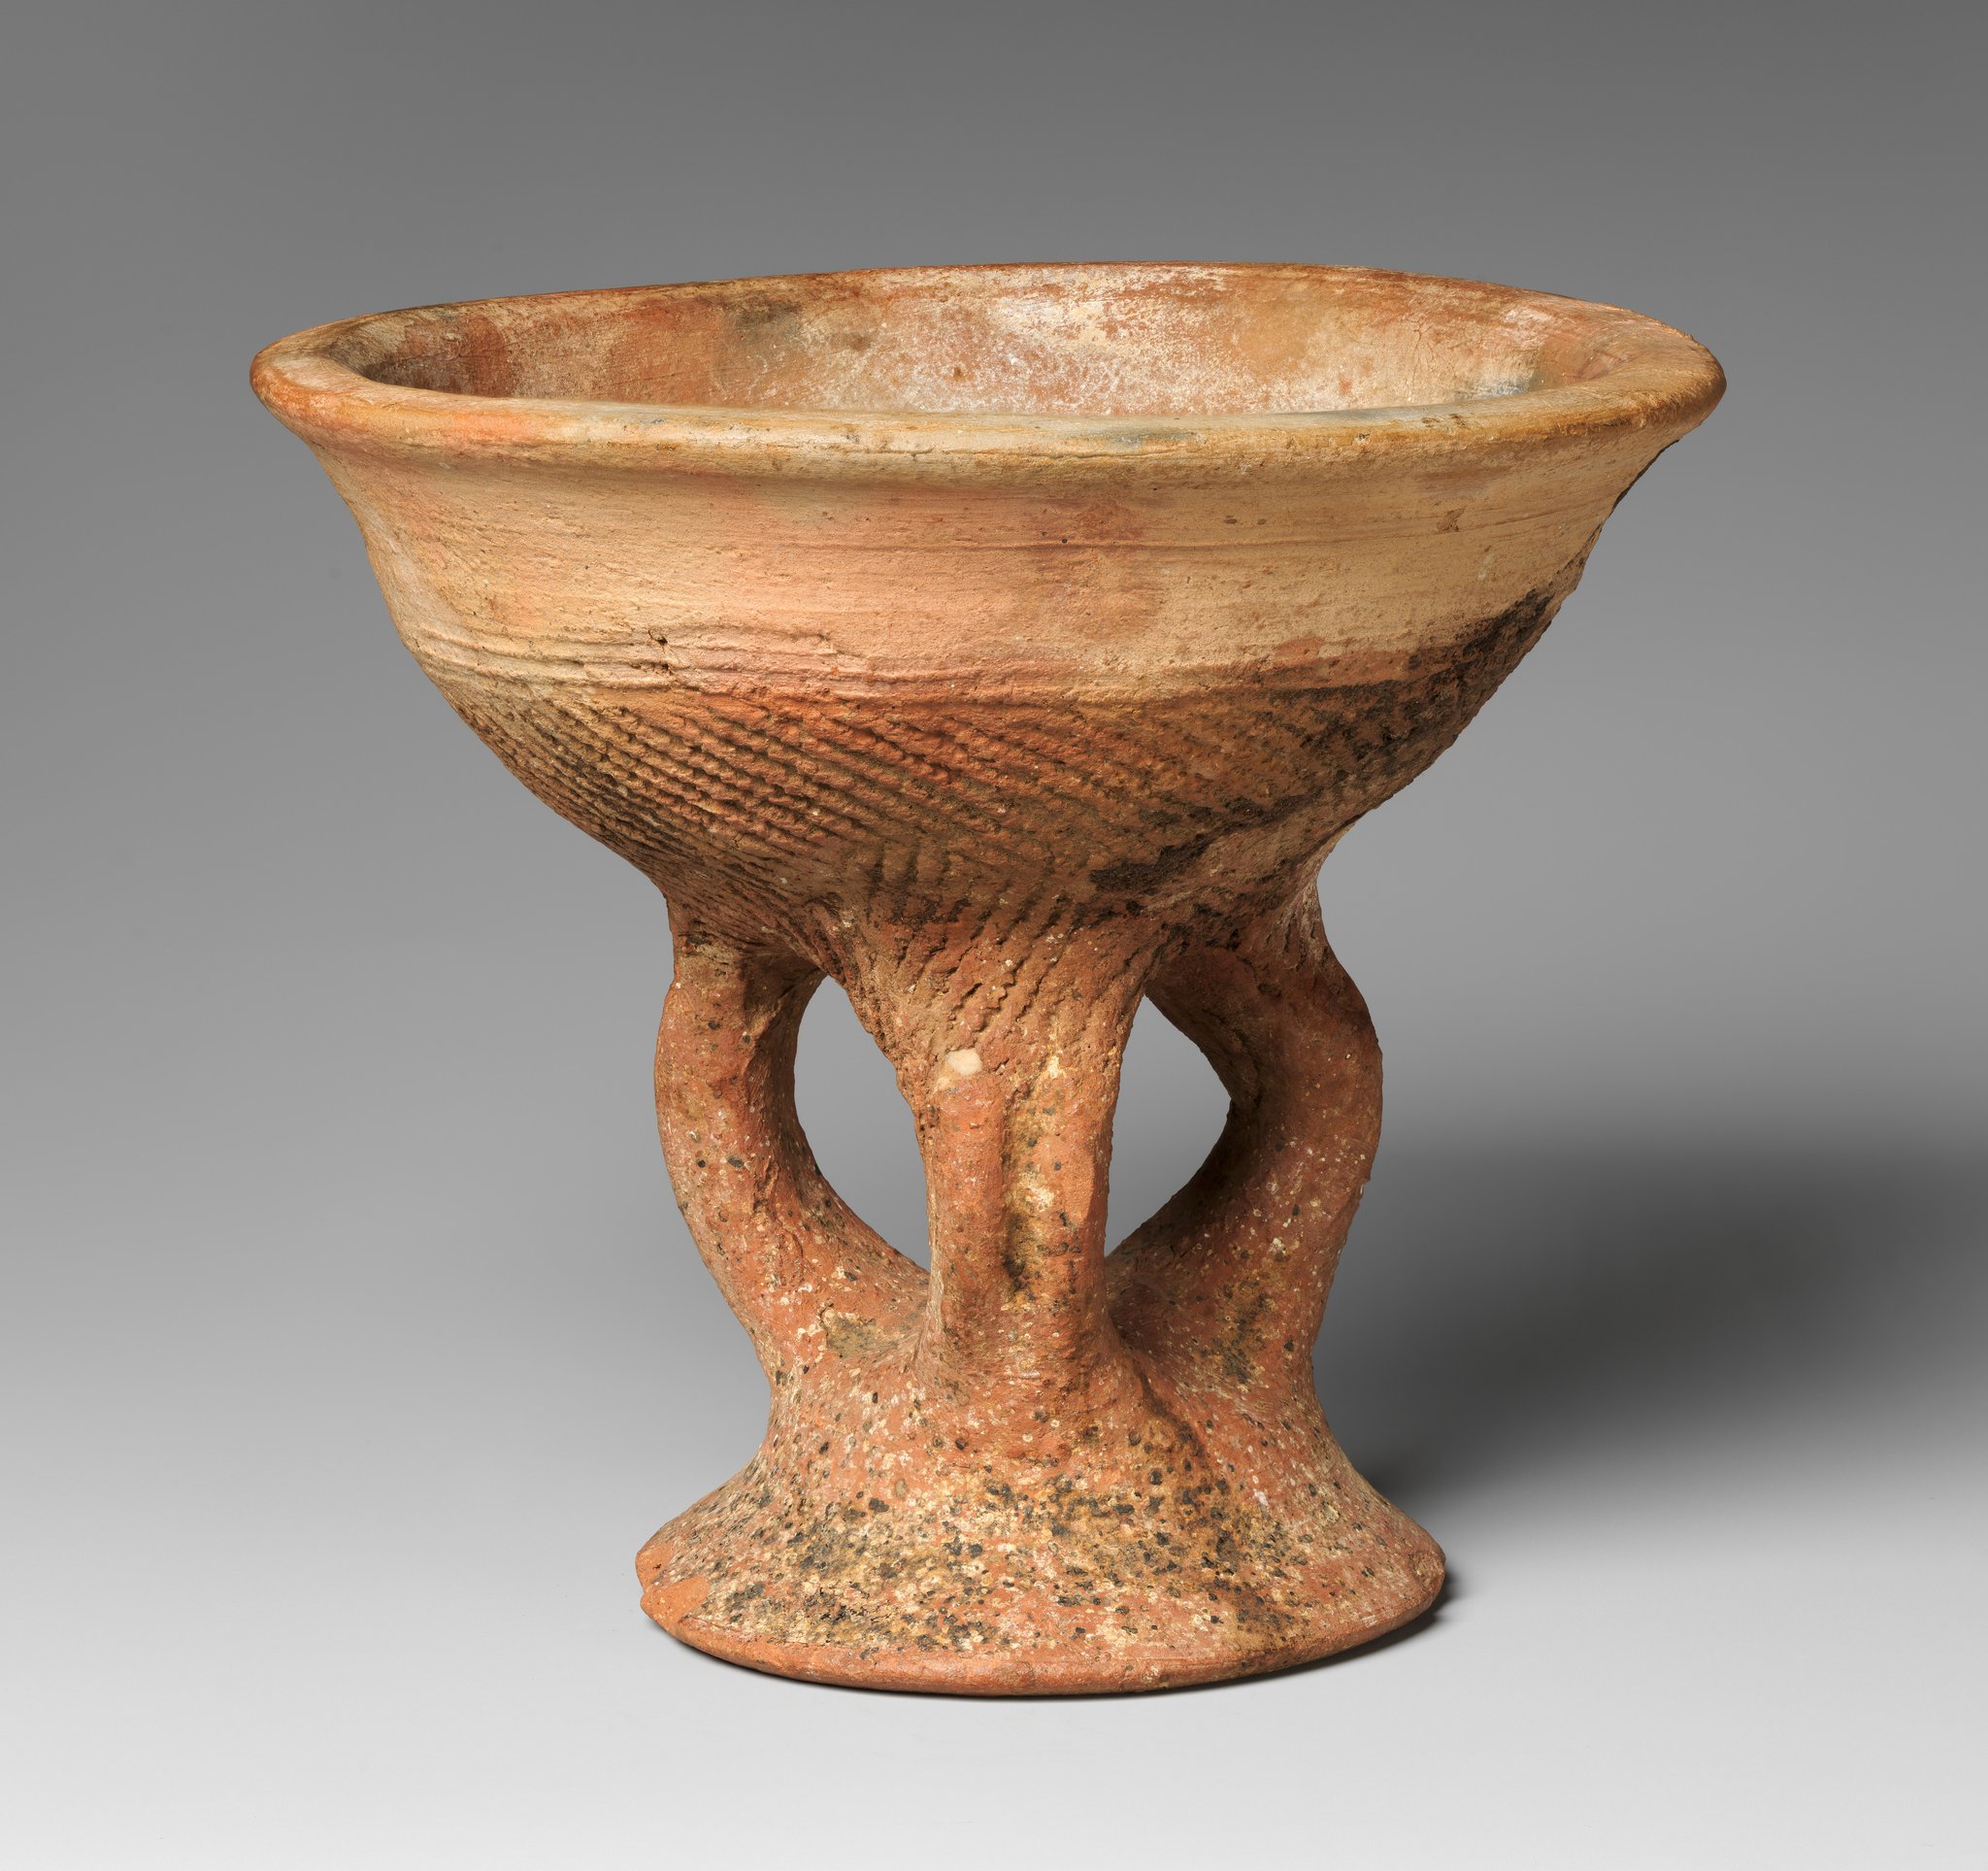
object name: vessel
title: Vessel with footed base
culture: tellem peoples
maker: tellem artist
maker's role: artist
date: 1301-1400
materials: terracotta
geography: mali